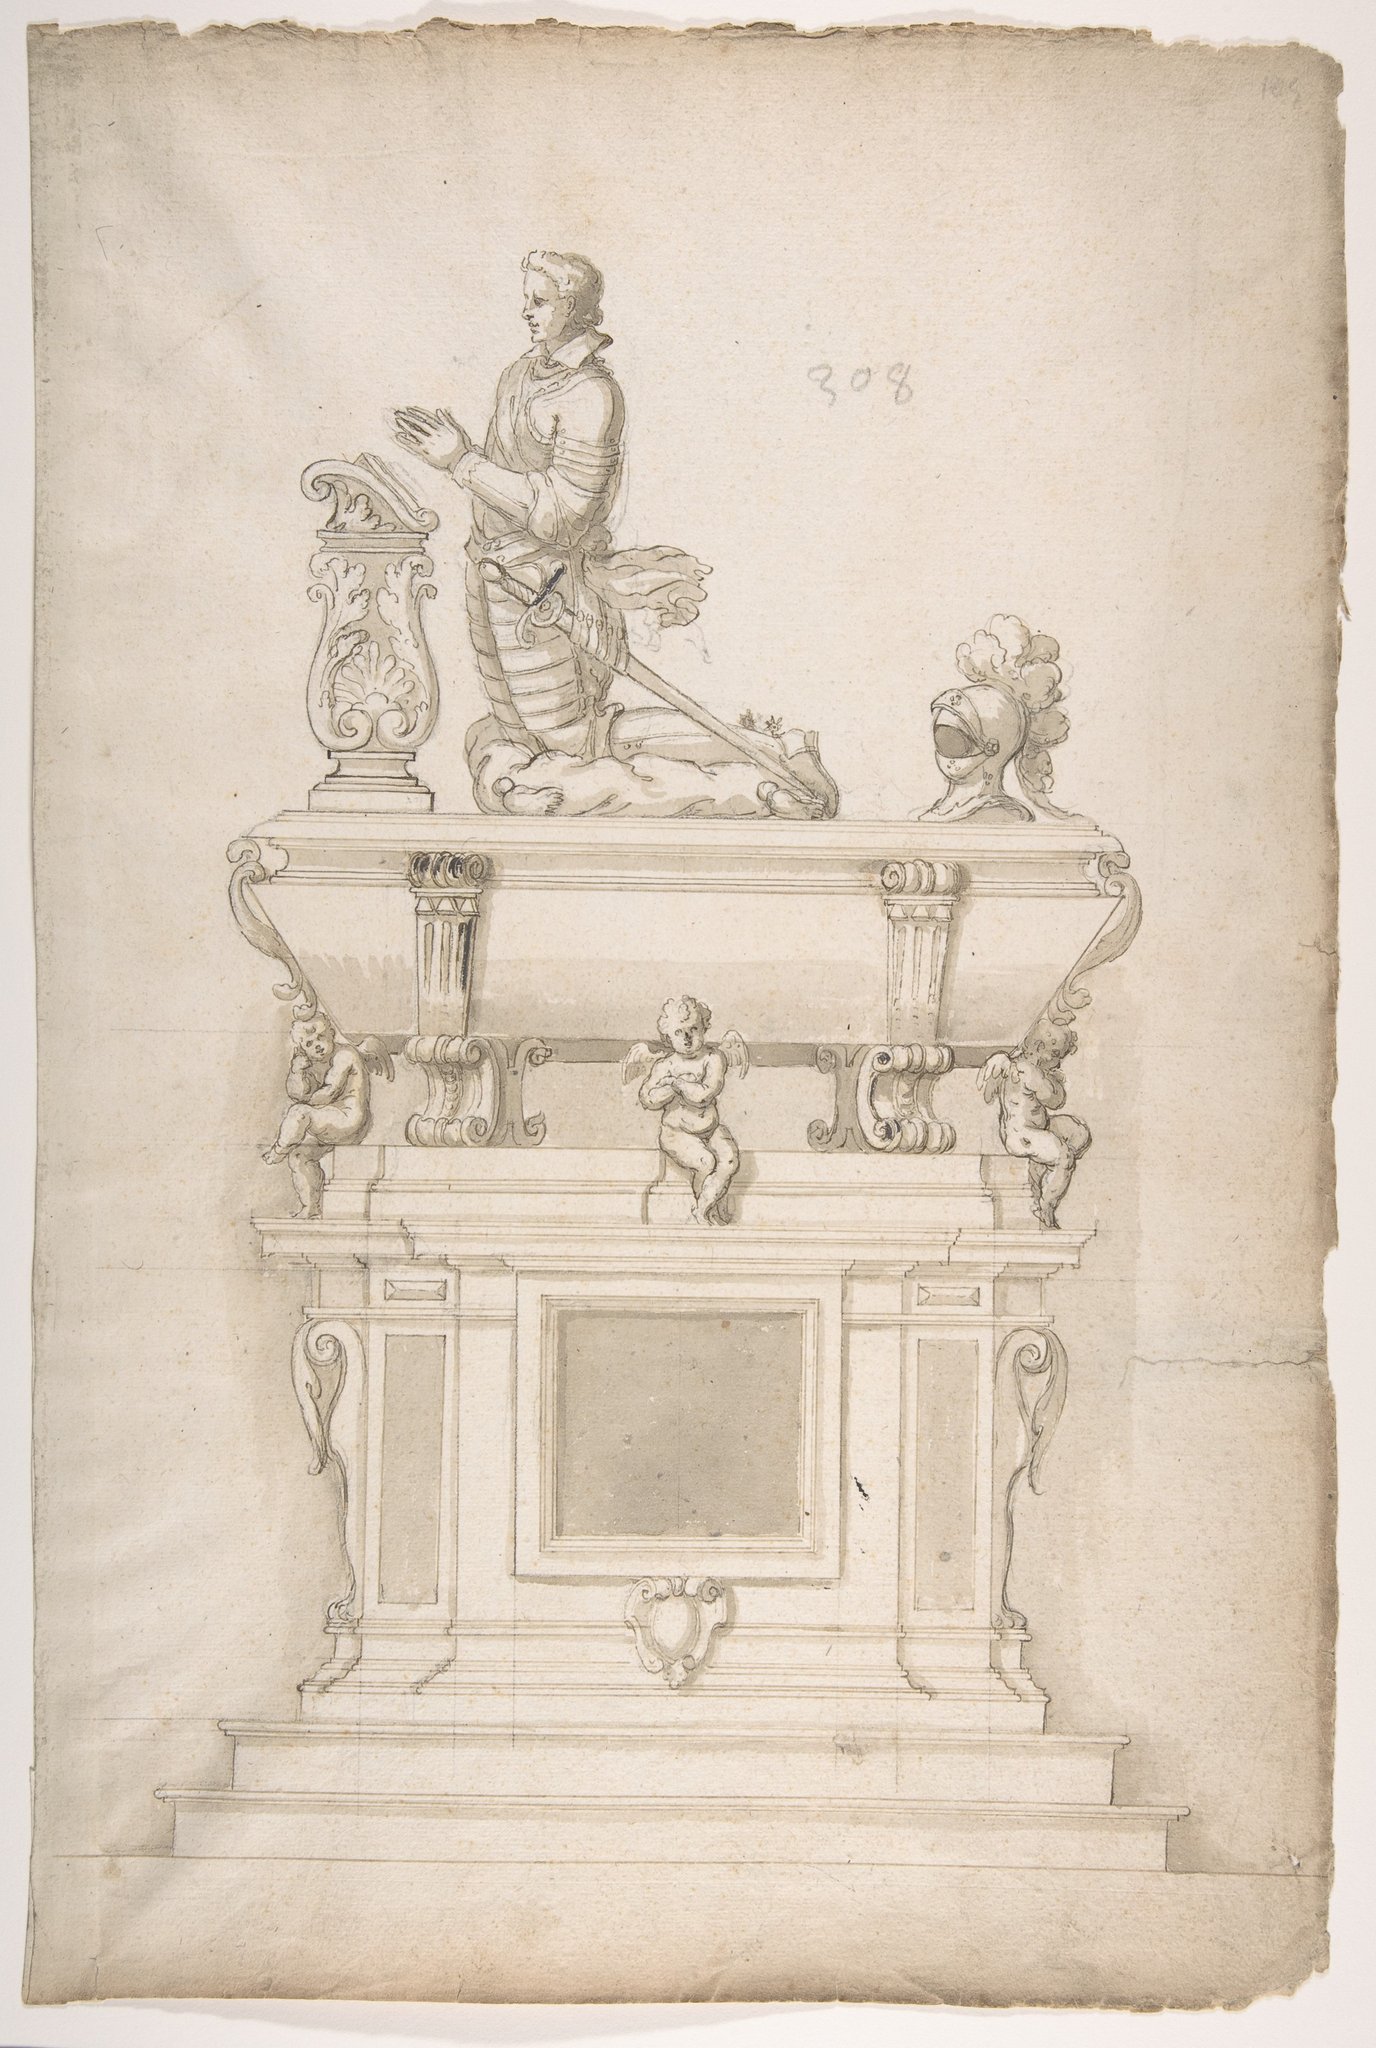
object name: drawing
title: Design for a Man's Tomb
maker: anonymous, french, 16th century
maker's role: artist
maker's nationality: french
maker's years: 1500-1600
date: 1501-1600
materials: chalk, ink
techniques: brush, pen, wash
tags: architecture,tombs